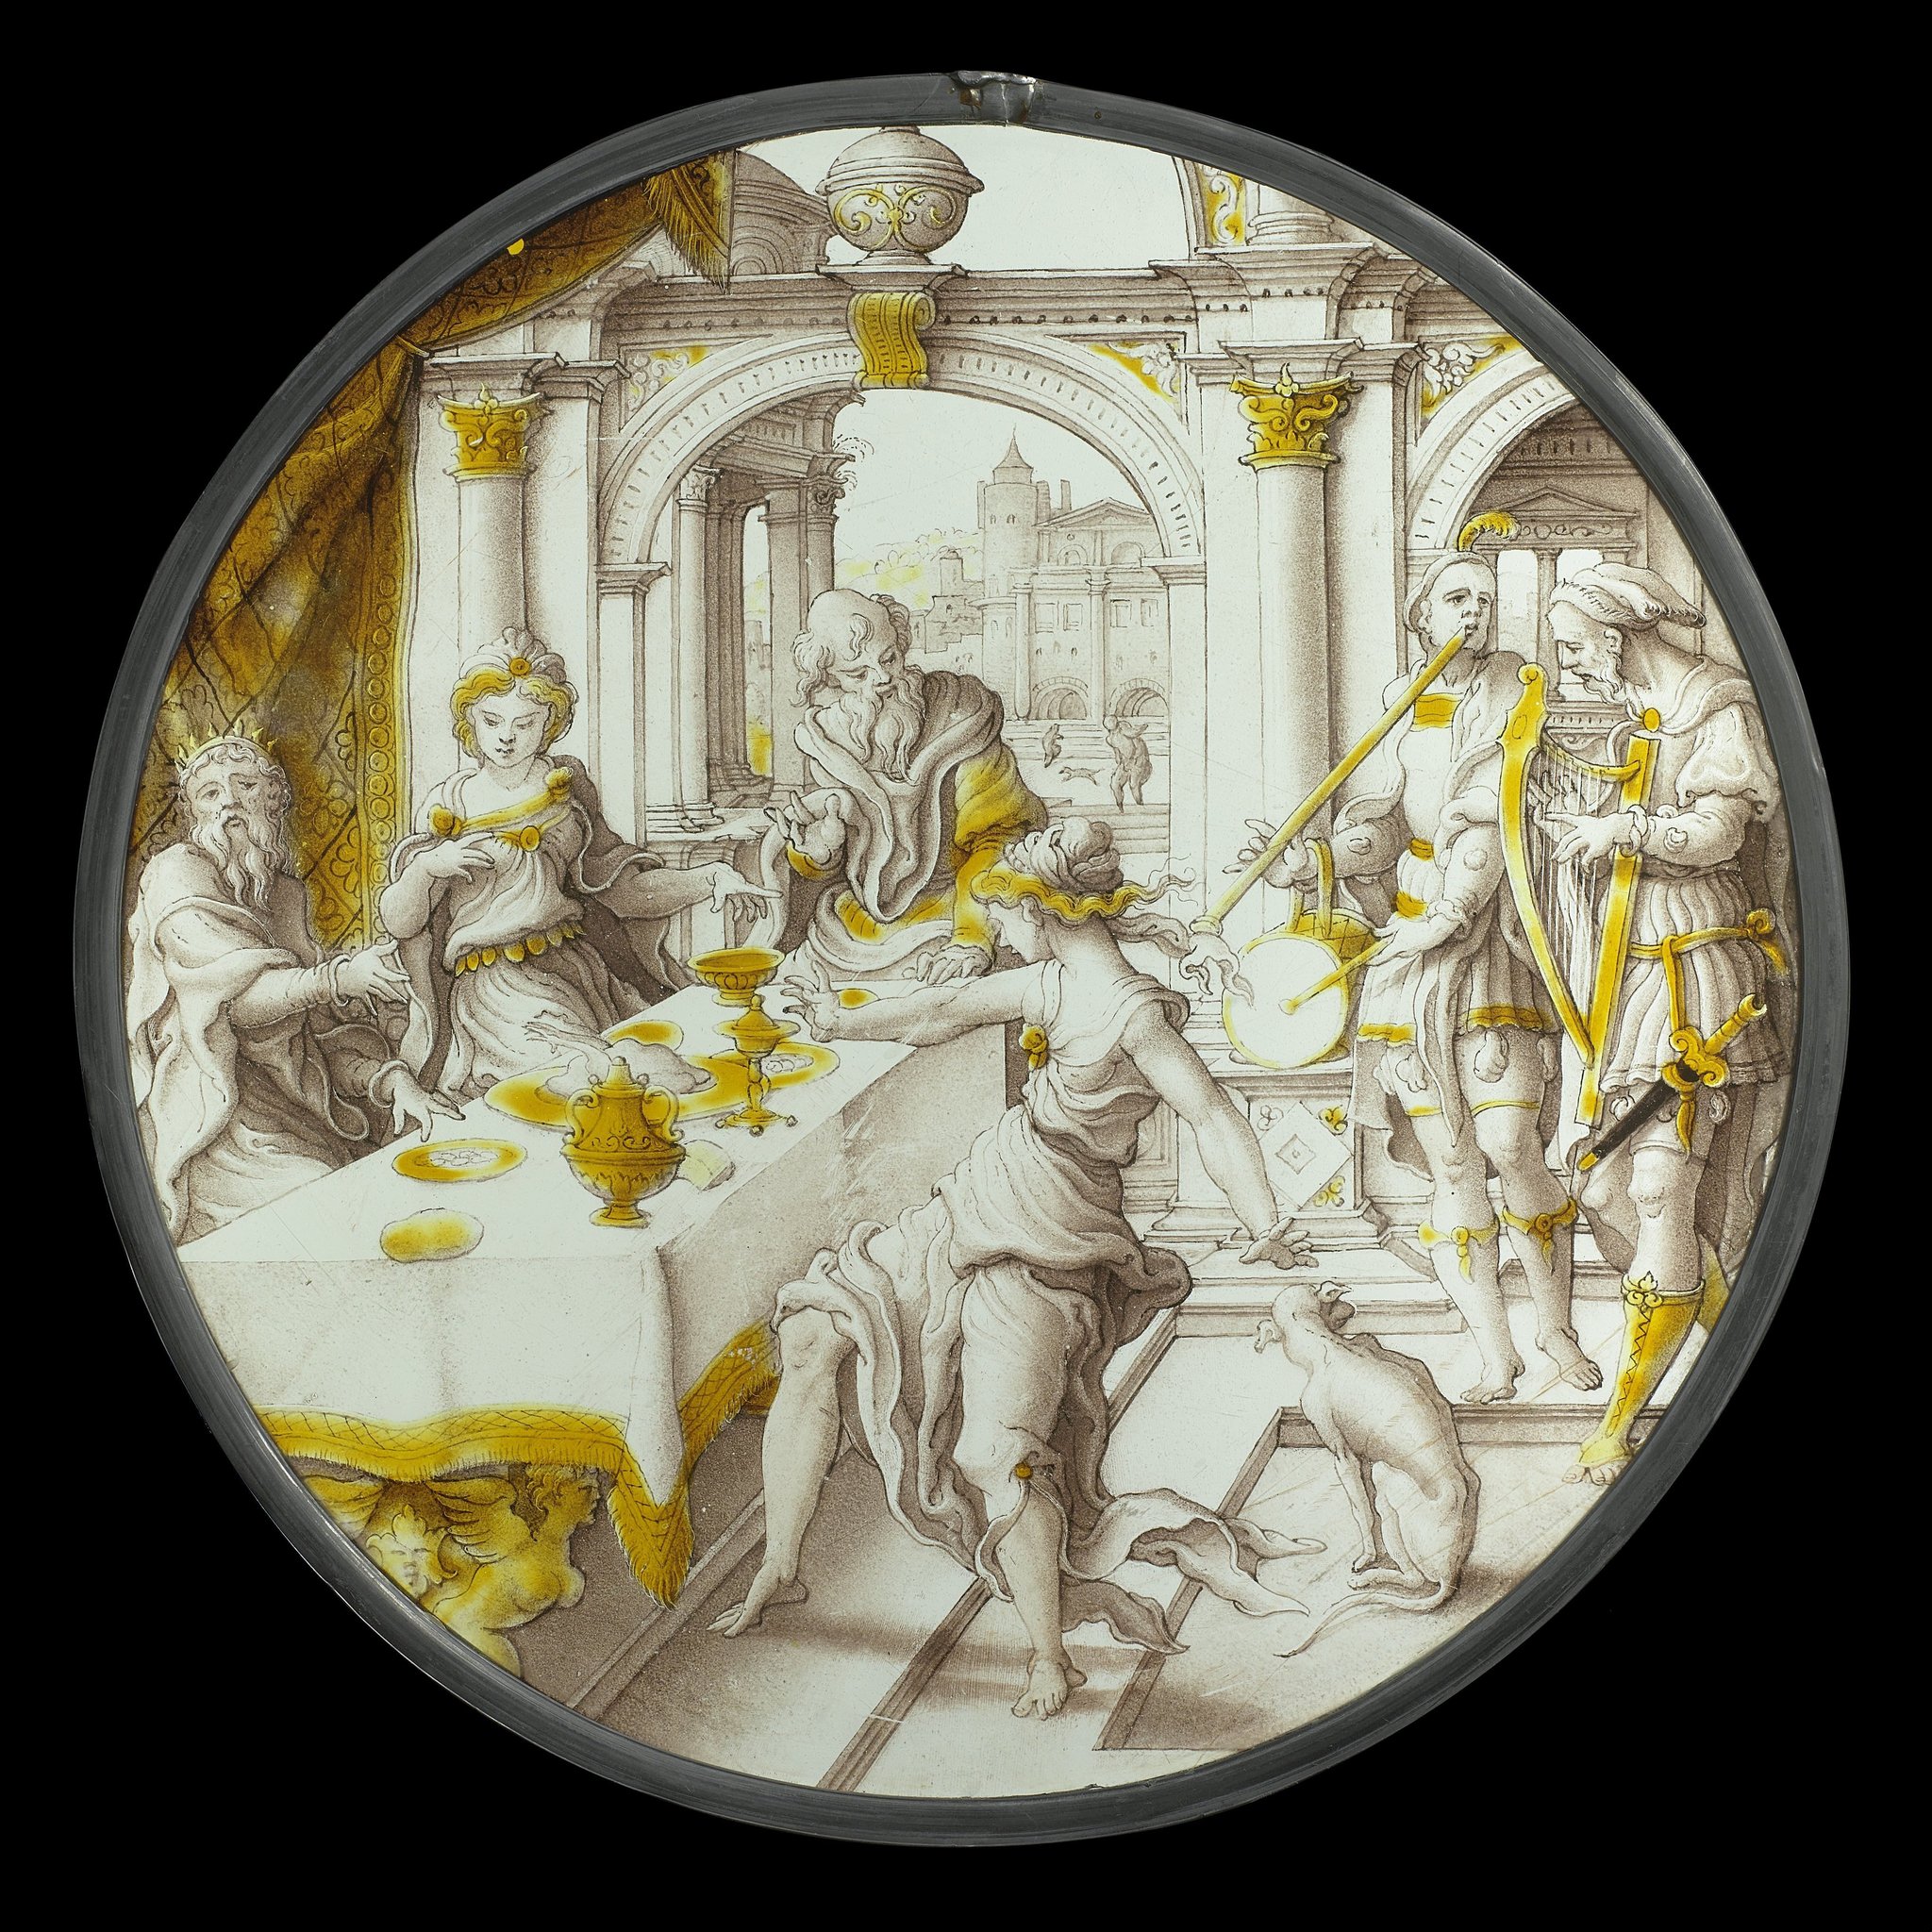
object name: light window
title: The Dance of Salome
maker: Anonymous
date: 1540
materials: glass, lead, pigment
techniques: leading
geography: southern netherlands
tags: tambourine, harp, salome dancing during the banquet of herod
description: Ronde gebrandschilderde ruit met voorstelling van De dans van Salomé. Achter de gedekte tafel zitten Herodes en Herodias. Johannes lijkt als gast mee aan te zitten. Salomé danst uitdagend op de treden van de estrade waarop de tafel staat. Recht twee muzikanten, de een blaast op een fluit en slaat op een tamboerijn, de ander bespeelt een harp.